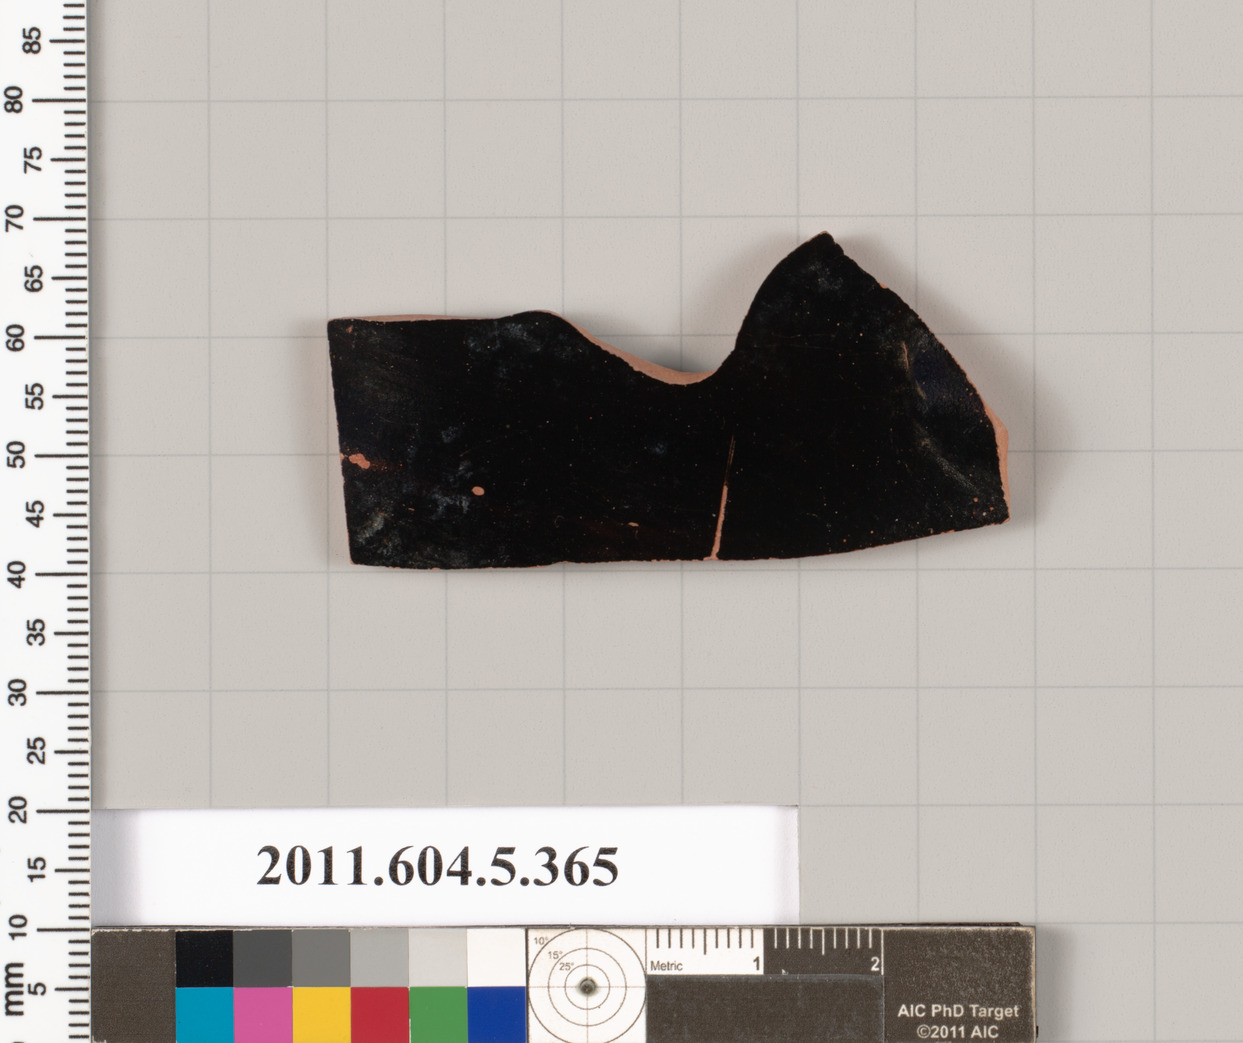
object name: kylix fragment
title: Terracotta fragment of a kylix (drinking cup)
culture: greek, attic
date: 600-401 BCE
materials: terracotta